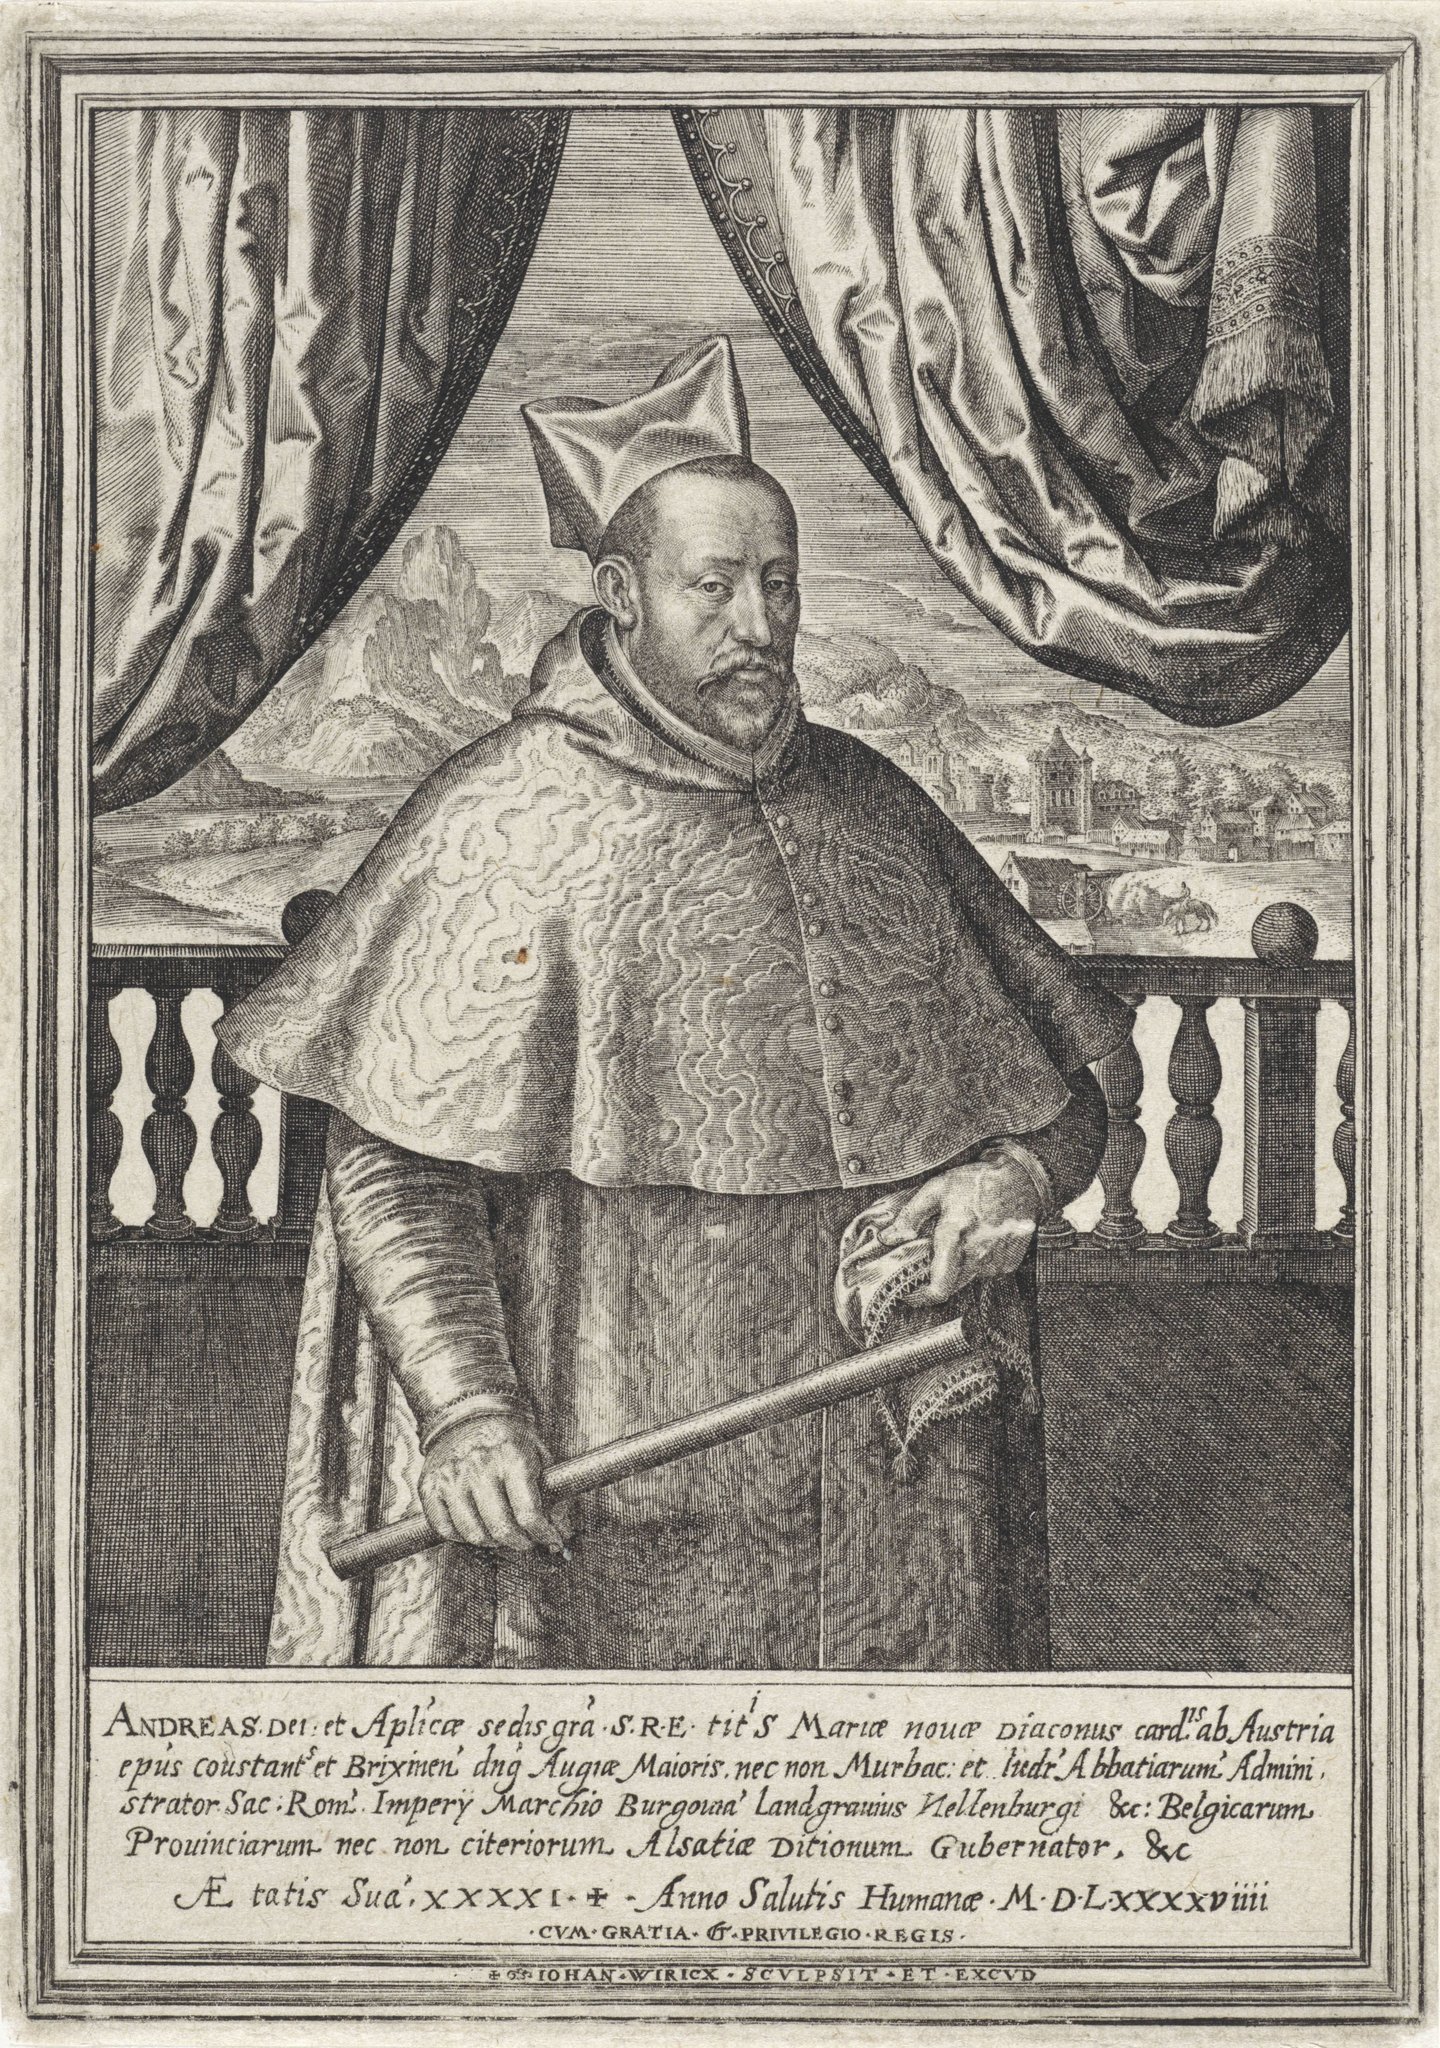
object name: print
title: Portret van Andreas van Oostenrijk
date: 1599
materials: paper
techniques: engraving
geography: antwerp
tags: watermill, insignia of cardinal, e.g. hat, mantle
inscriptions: collector's mark: Lugt 2228, number: ‘22. - 48.’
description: Portret van Andreas van Oostenrijk, kardinaal-deken en plaatsvervangend gouverneur-generaal van de Zuidelijke Nederlanden. Hij heeft een commandostaf in de hand. Op de achtergrond een landschap met een watermolen. In de marge een vijfregelig onderschrift in het Latijn.